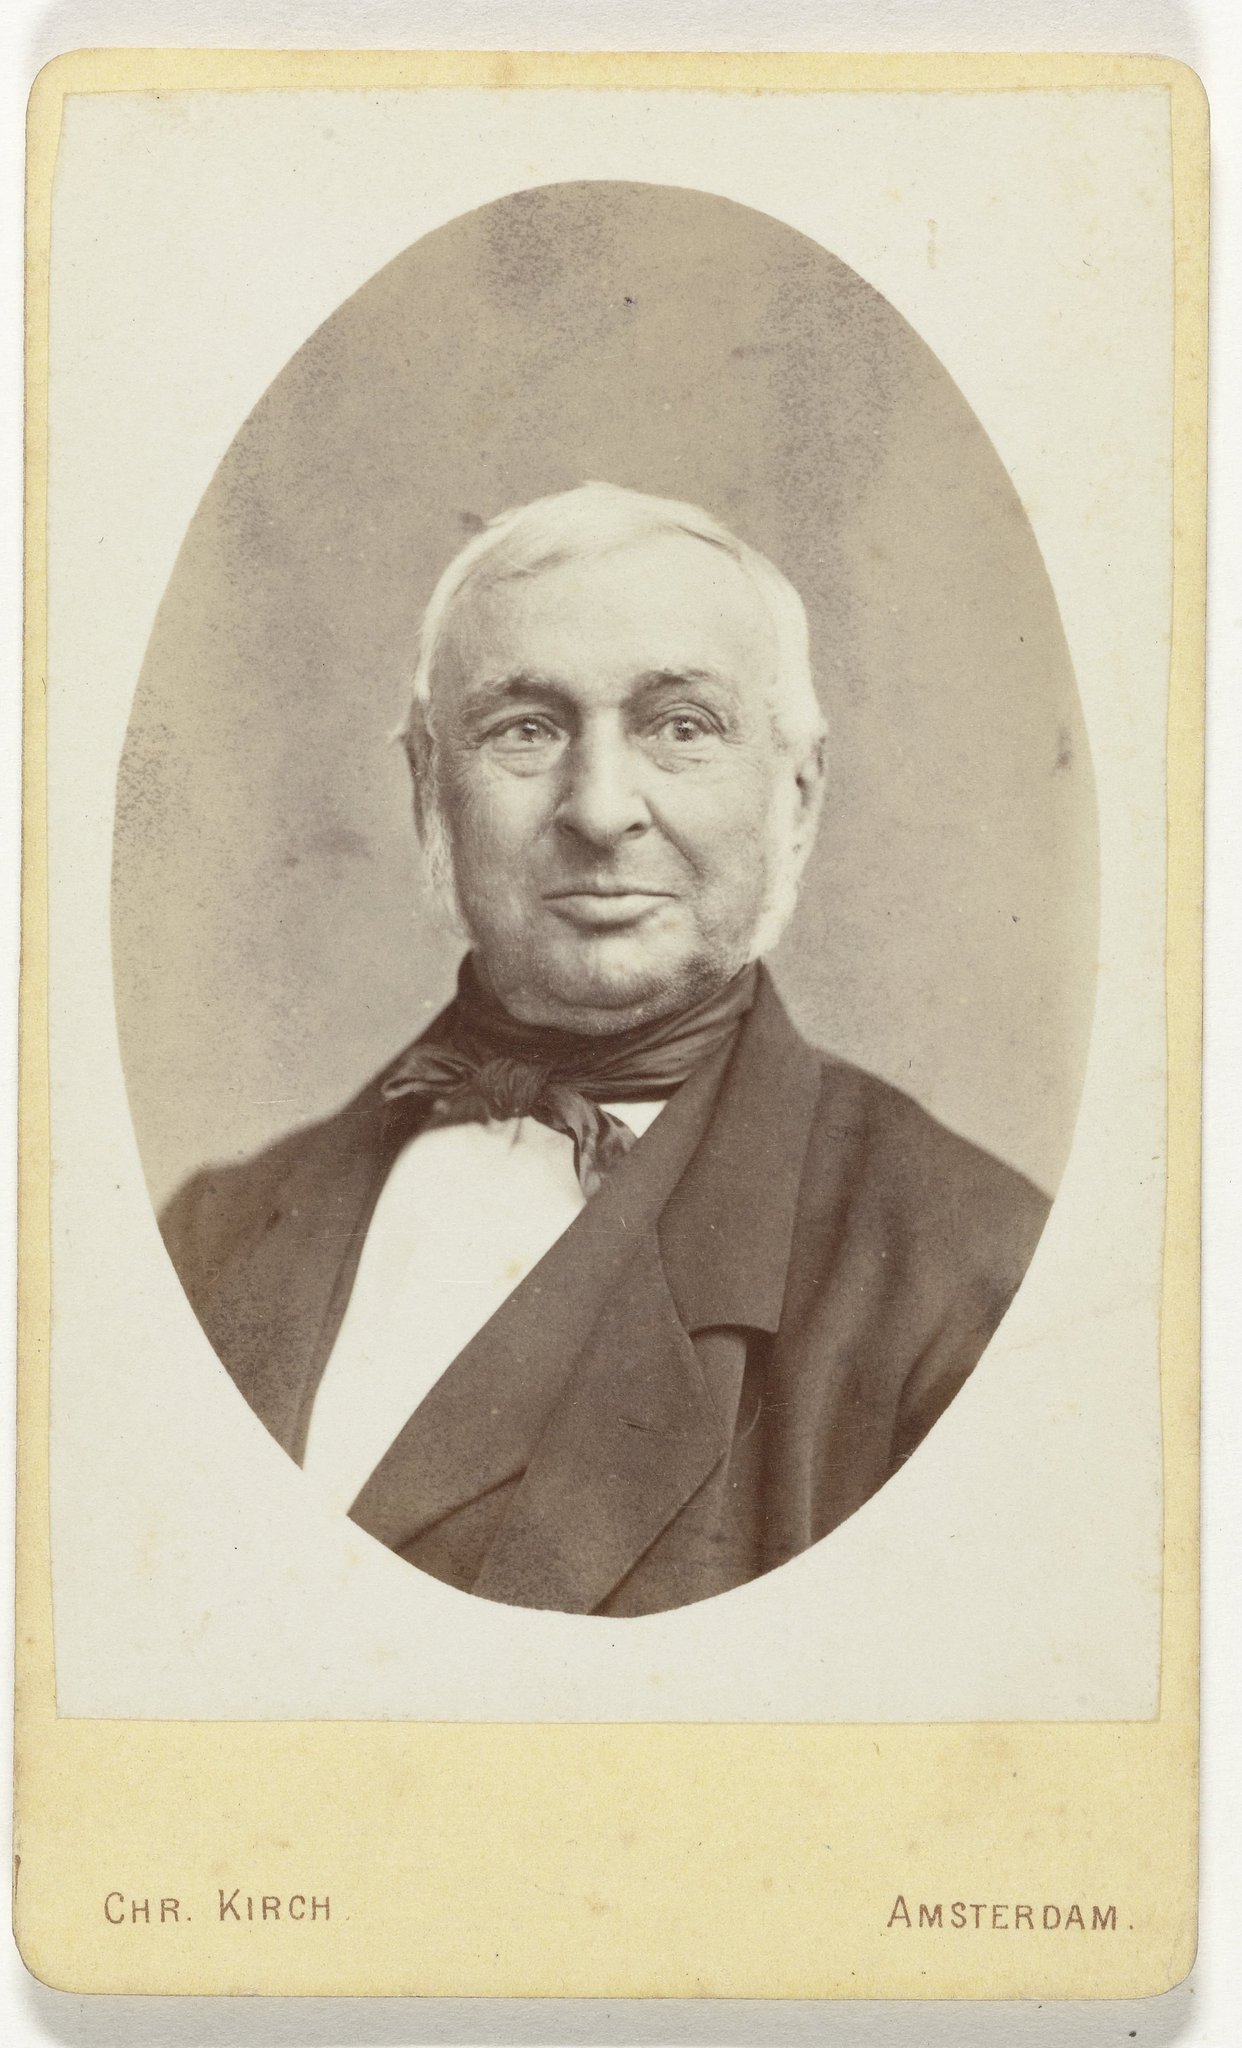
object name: photograph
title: Portret van een man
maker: christian theodor kirch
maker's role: fotograaf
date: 1869-1879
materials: cardboard, paper, photographic support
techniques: albumen print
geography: amsterdam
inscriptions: address: ‘Photographie/Chr. Kirch/Amsterdam/179, Kalverstraat over den Heyligenweg’, annotation: ‘Het cliche wordt voor verdere bestellingen bewaard.’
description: Kop van een oudere man met wit haar, en face, in ovaal.